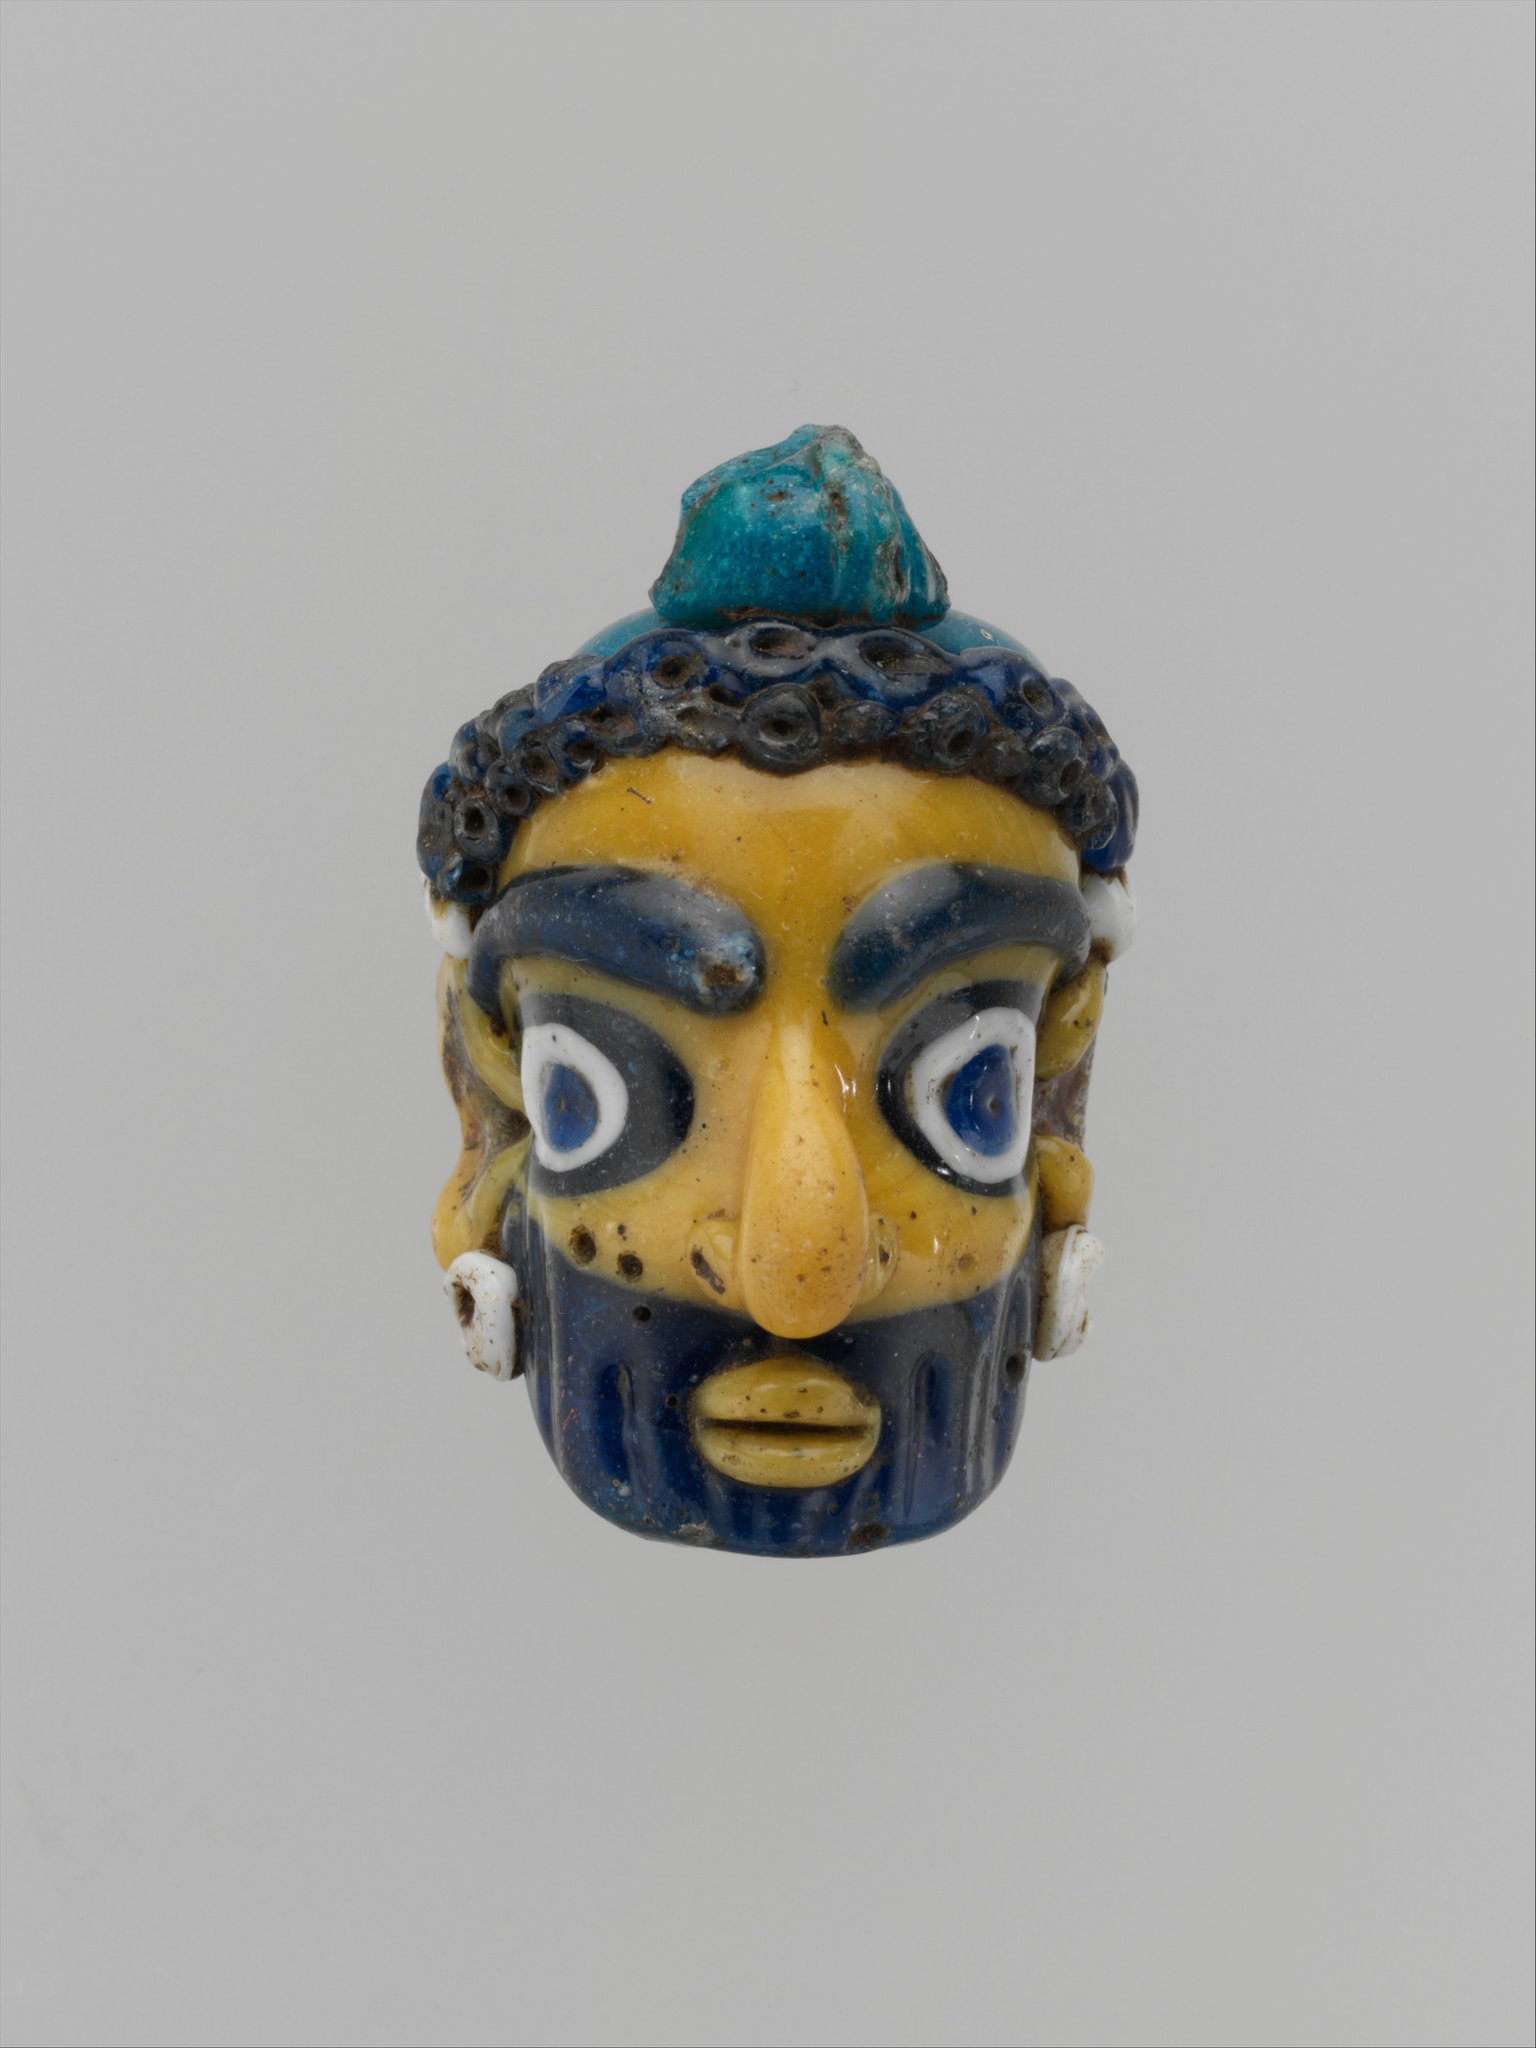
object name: head pendant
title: Glass head pendant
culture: carthaginian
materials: glass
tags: heads,men